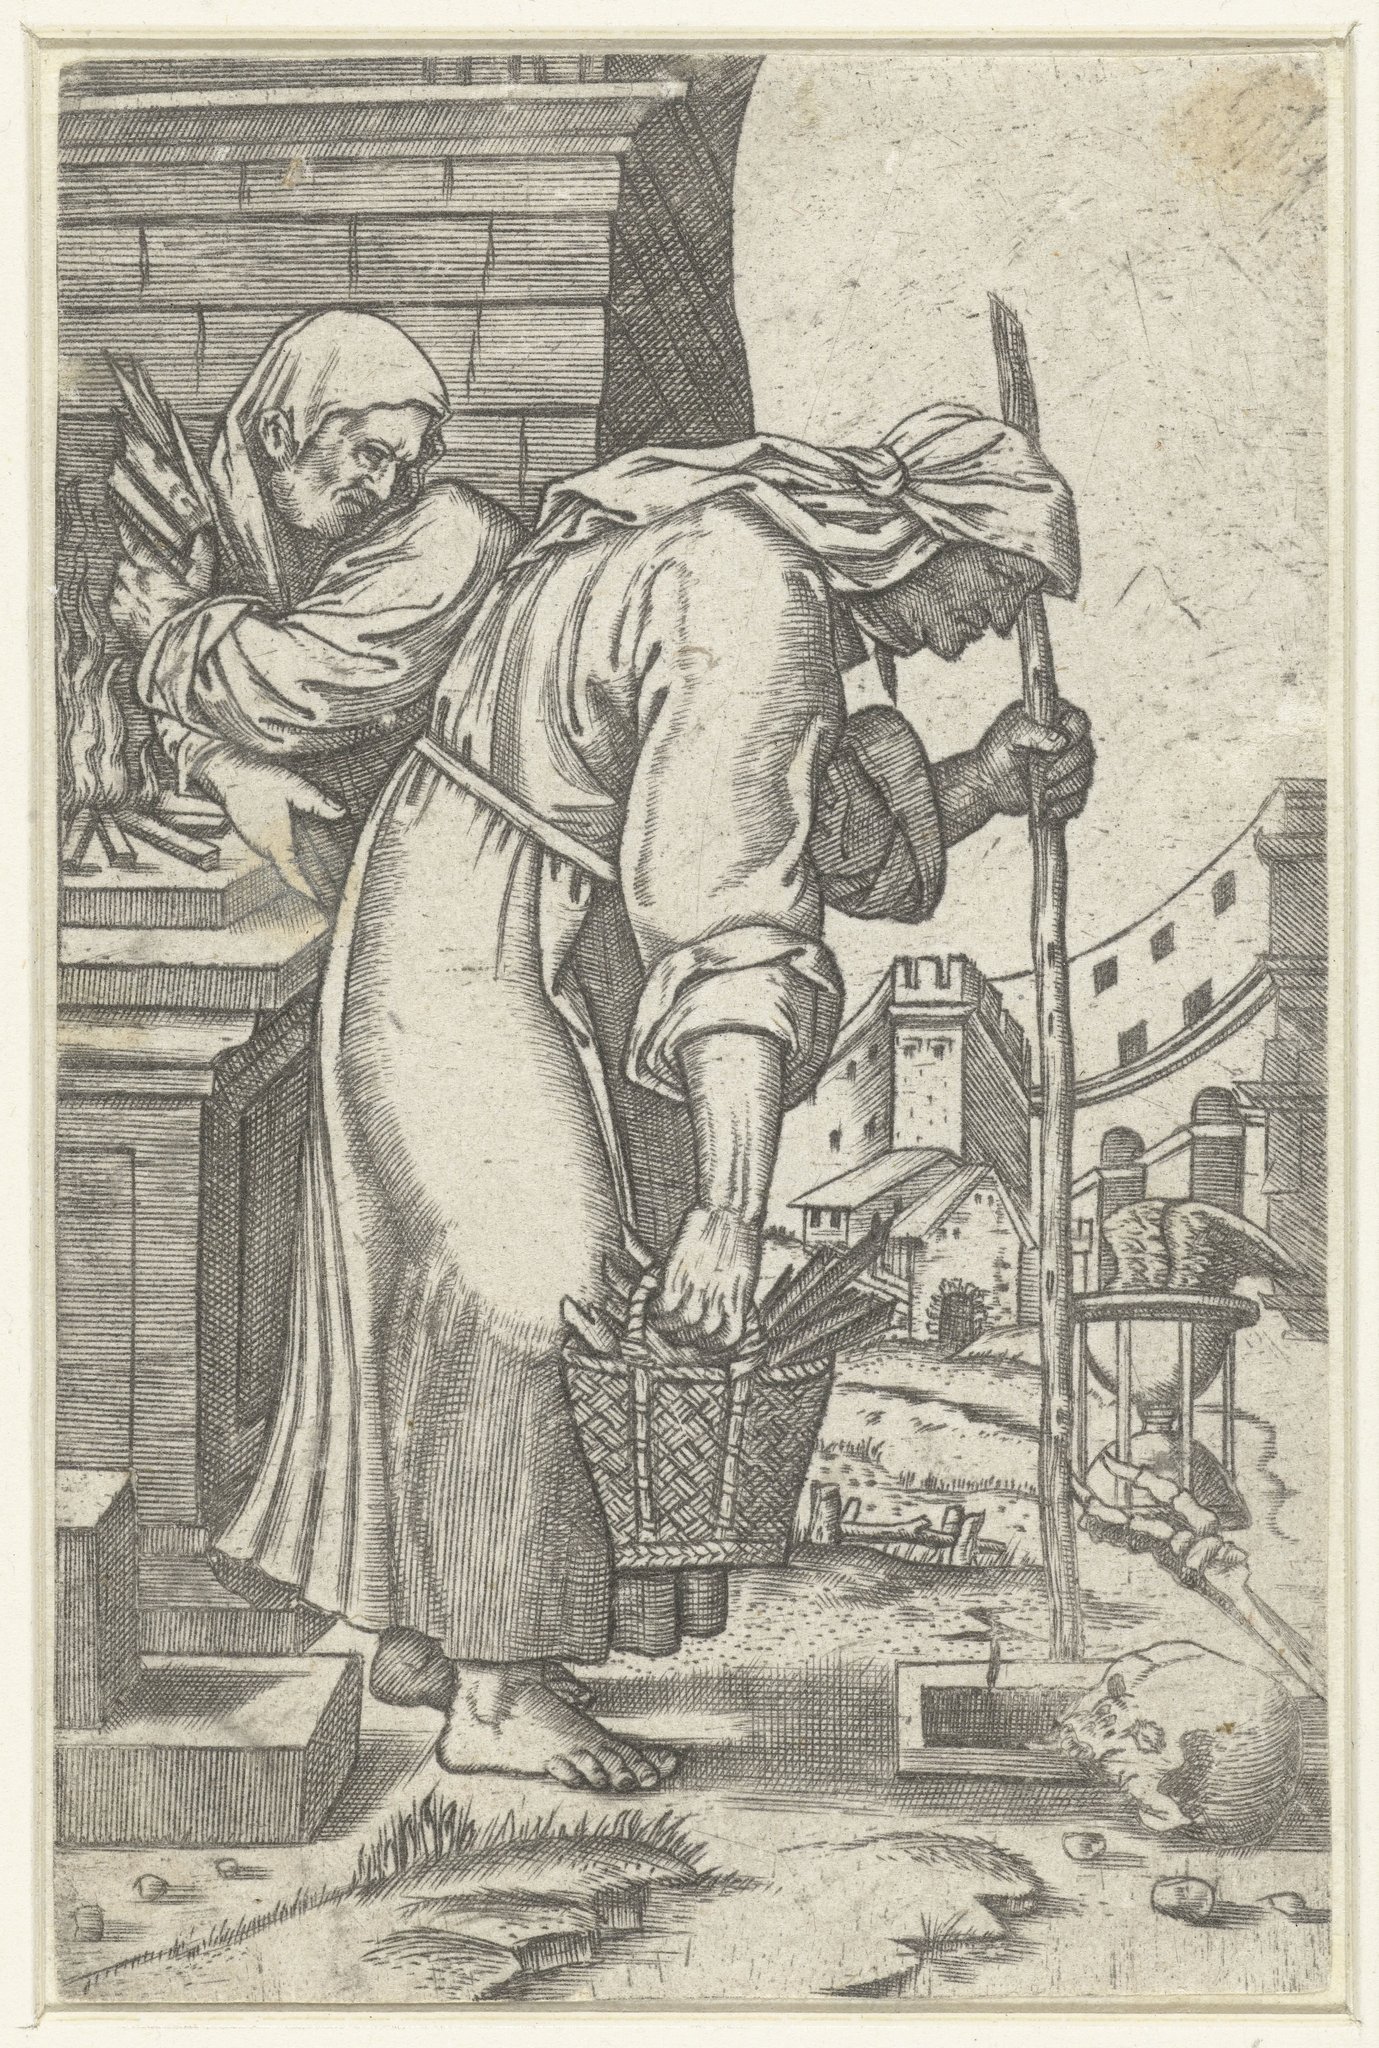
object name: print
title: Oude vrouw nadert haar graf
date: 1510-1527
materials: paper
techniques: engraving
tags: symbols of death, the ages of man (+ old female (human being)), hourglass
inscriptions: collector's mark: Lugt 240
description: Oude vrouw met mand met sprokkelhout loopt met gebogen rug en stok richting een open graf waar een skeletarm een gevleugelde zandloper toont.